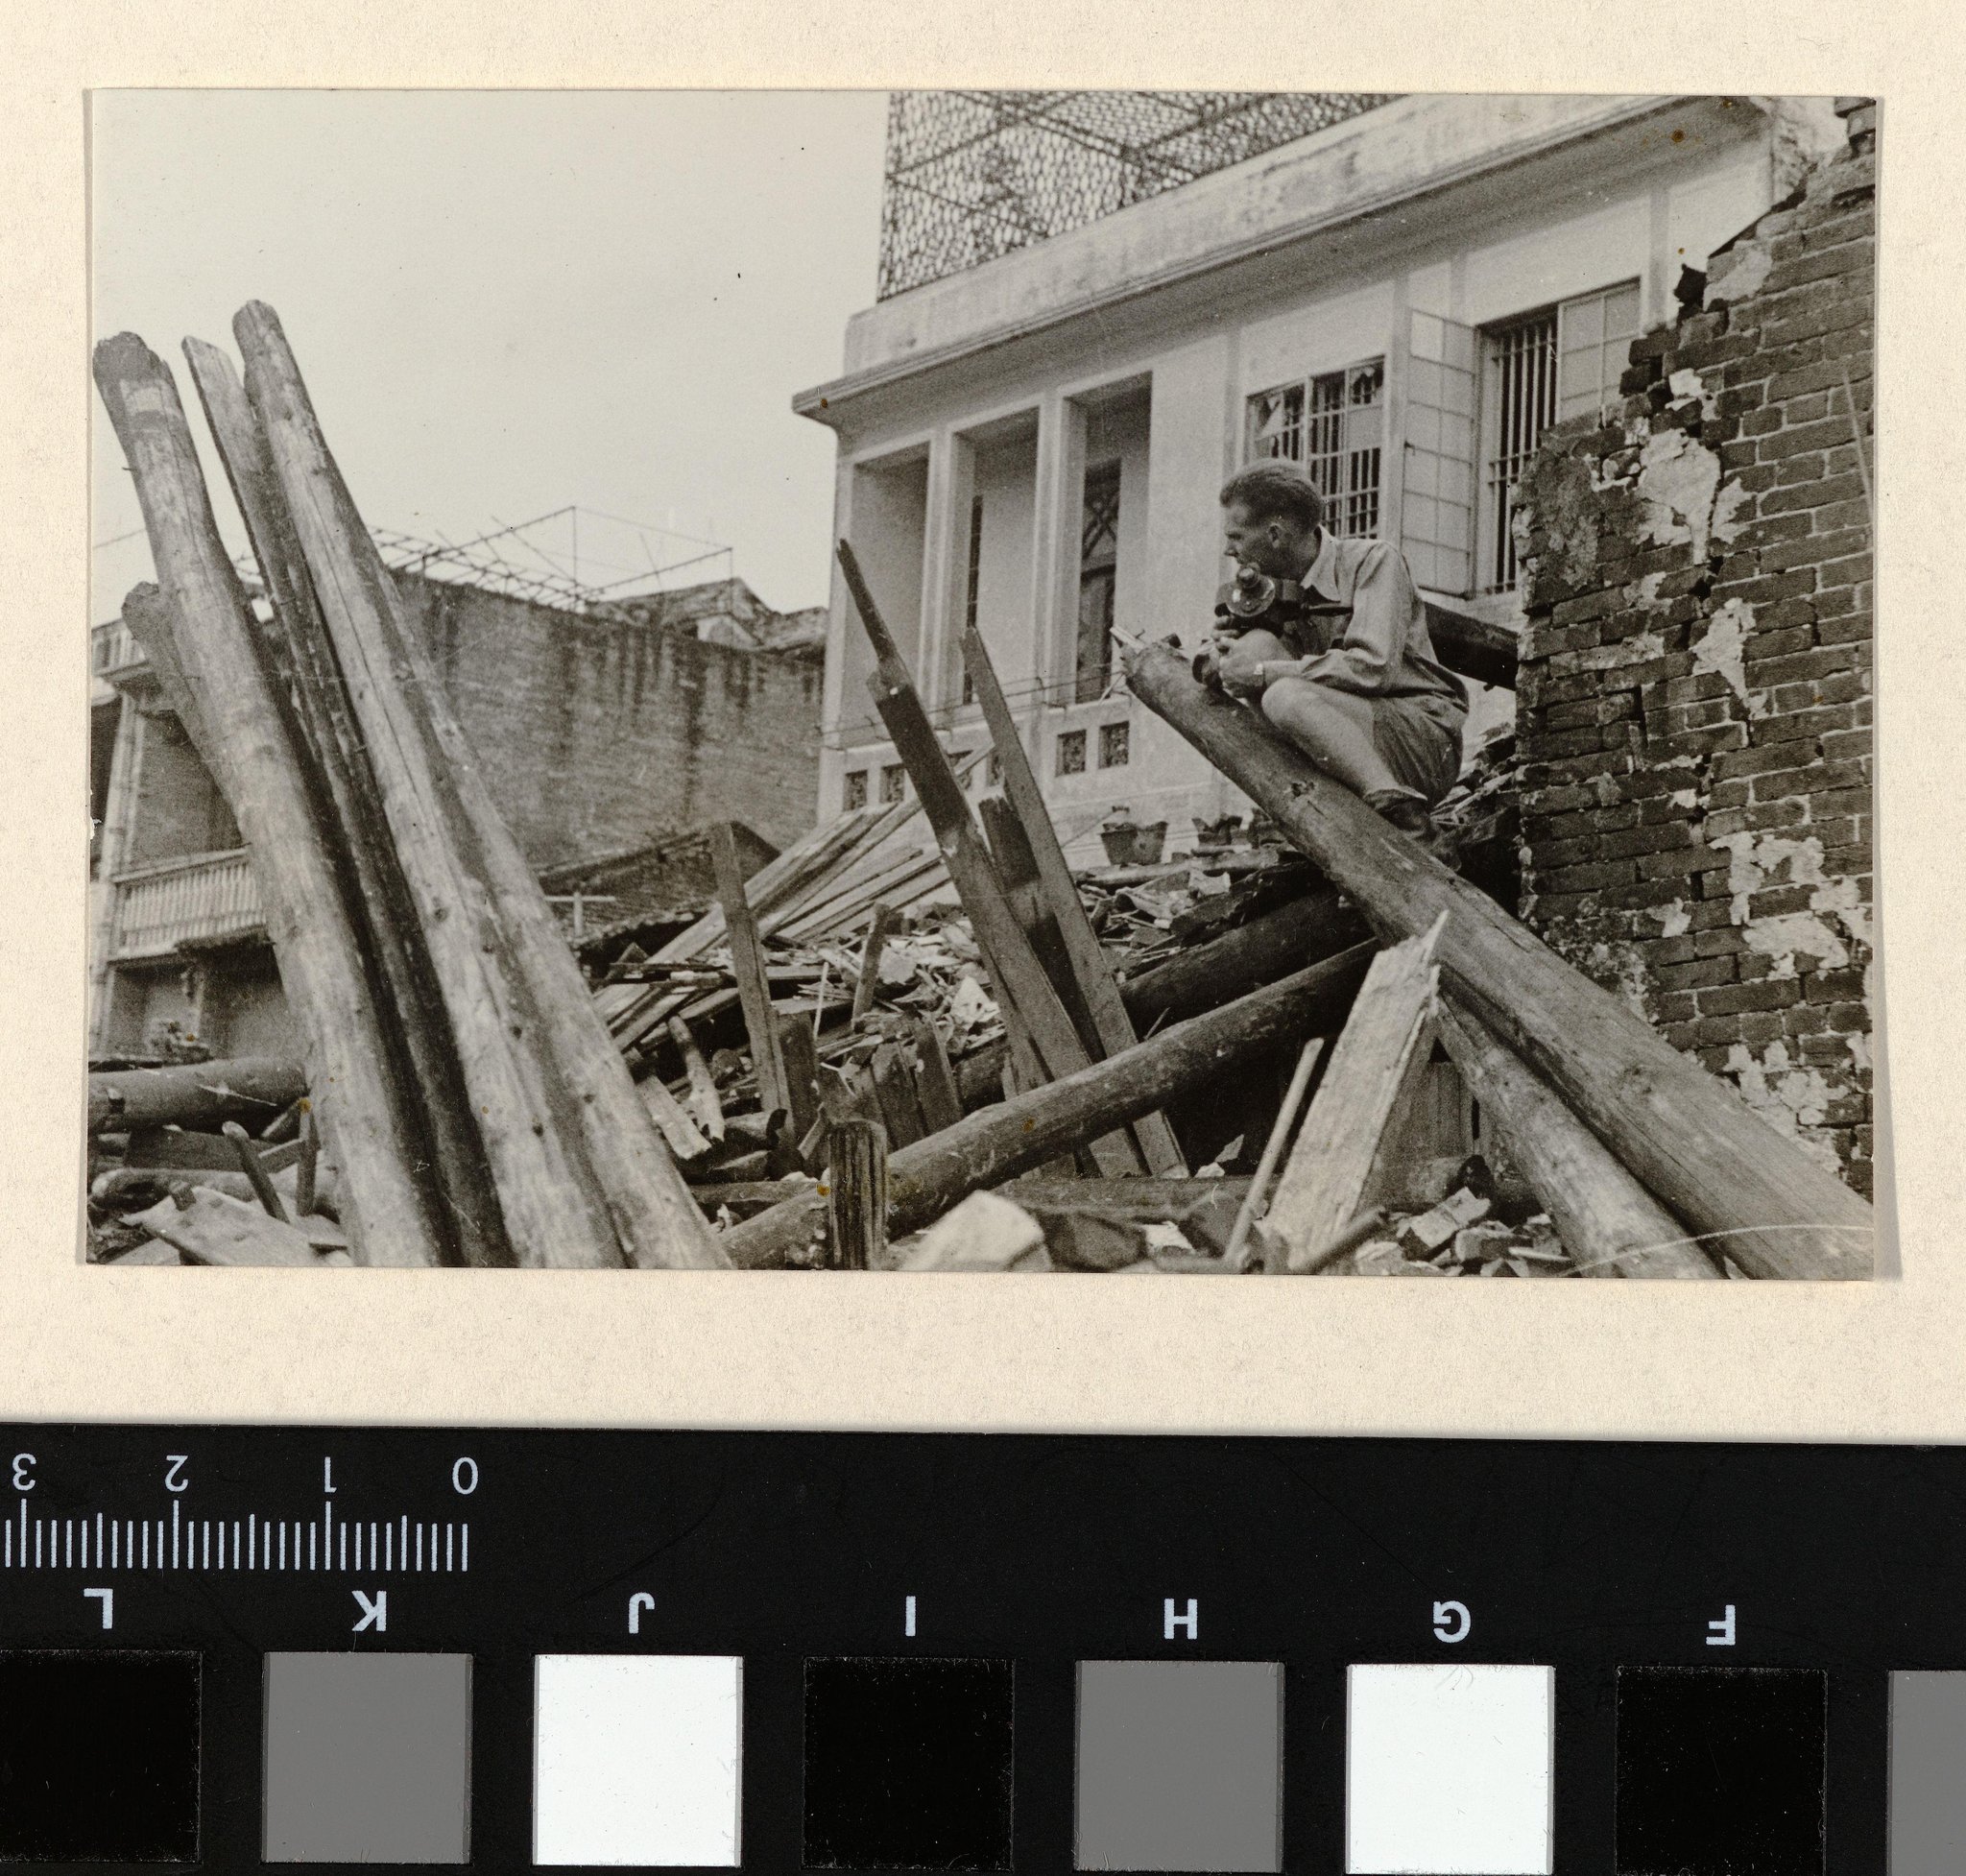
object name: photograph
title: John Fernhout met een camera op een ingestort gebouw, China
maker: robert capa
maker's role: fotograaf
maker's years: 1913-1954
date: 1938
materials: paper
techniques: gelatin silver print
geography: china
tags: john fernhout, photographer at work - cc - out of doors, ruin of a building ~ architecture, china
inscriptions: inscription: ‘probably Capa’